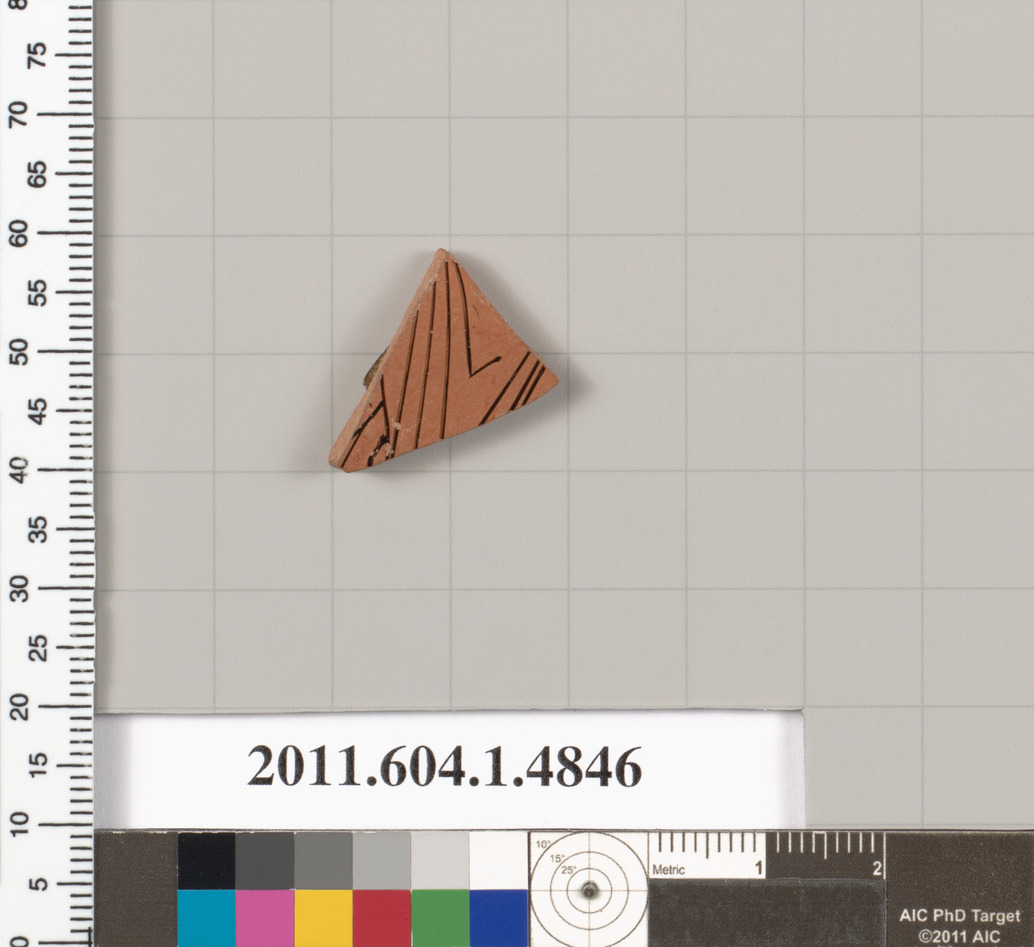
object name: kylix fragment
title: Terracotta fragment of a kylix (drinking cup)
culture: greek, attic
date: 475-451 BCE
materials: terracotta